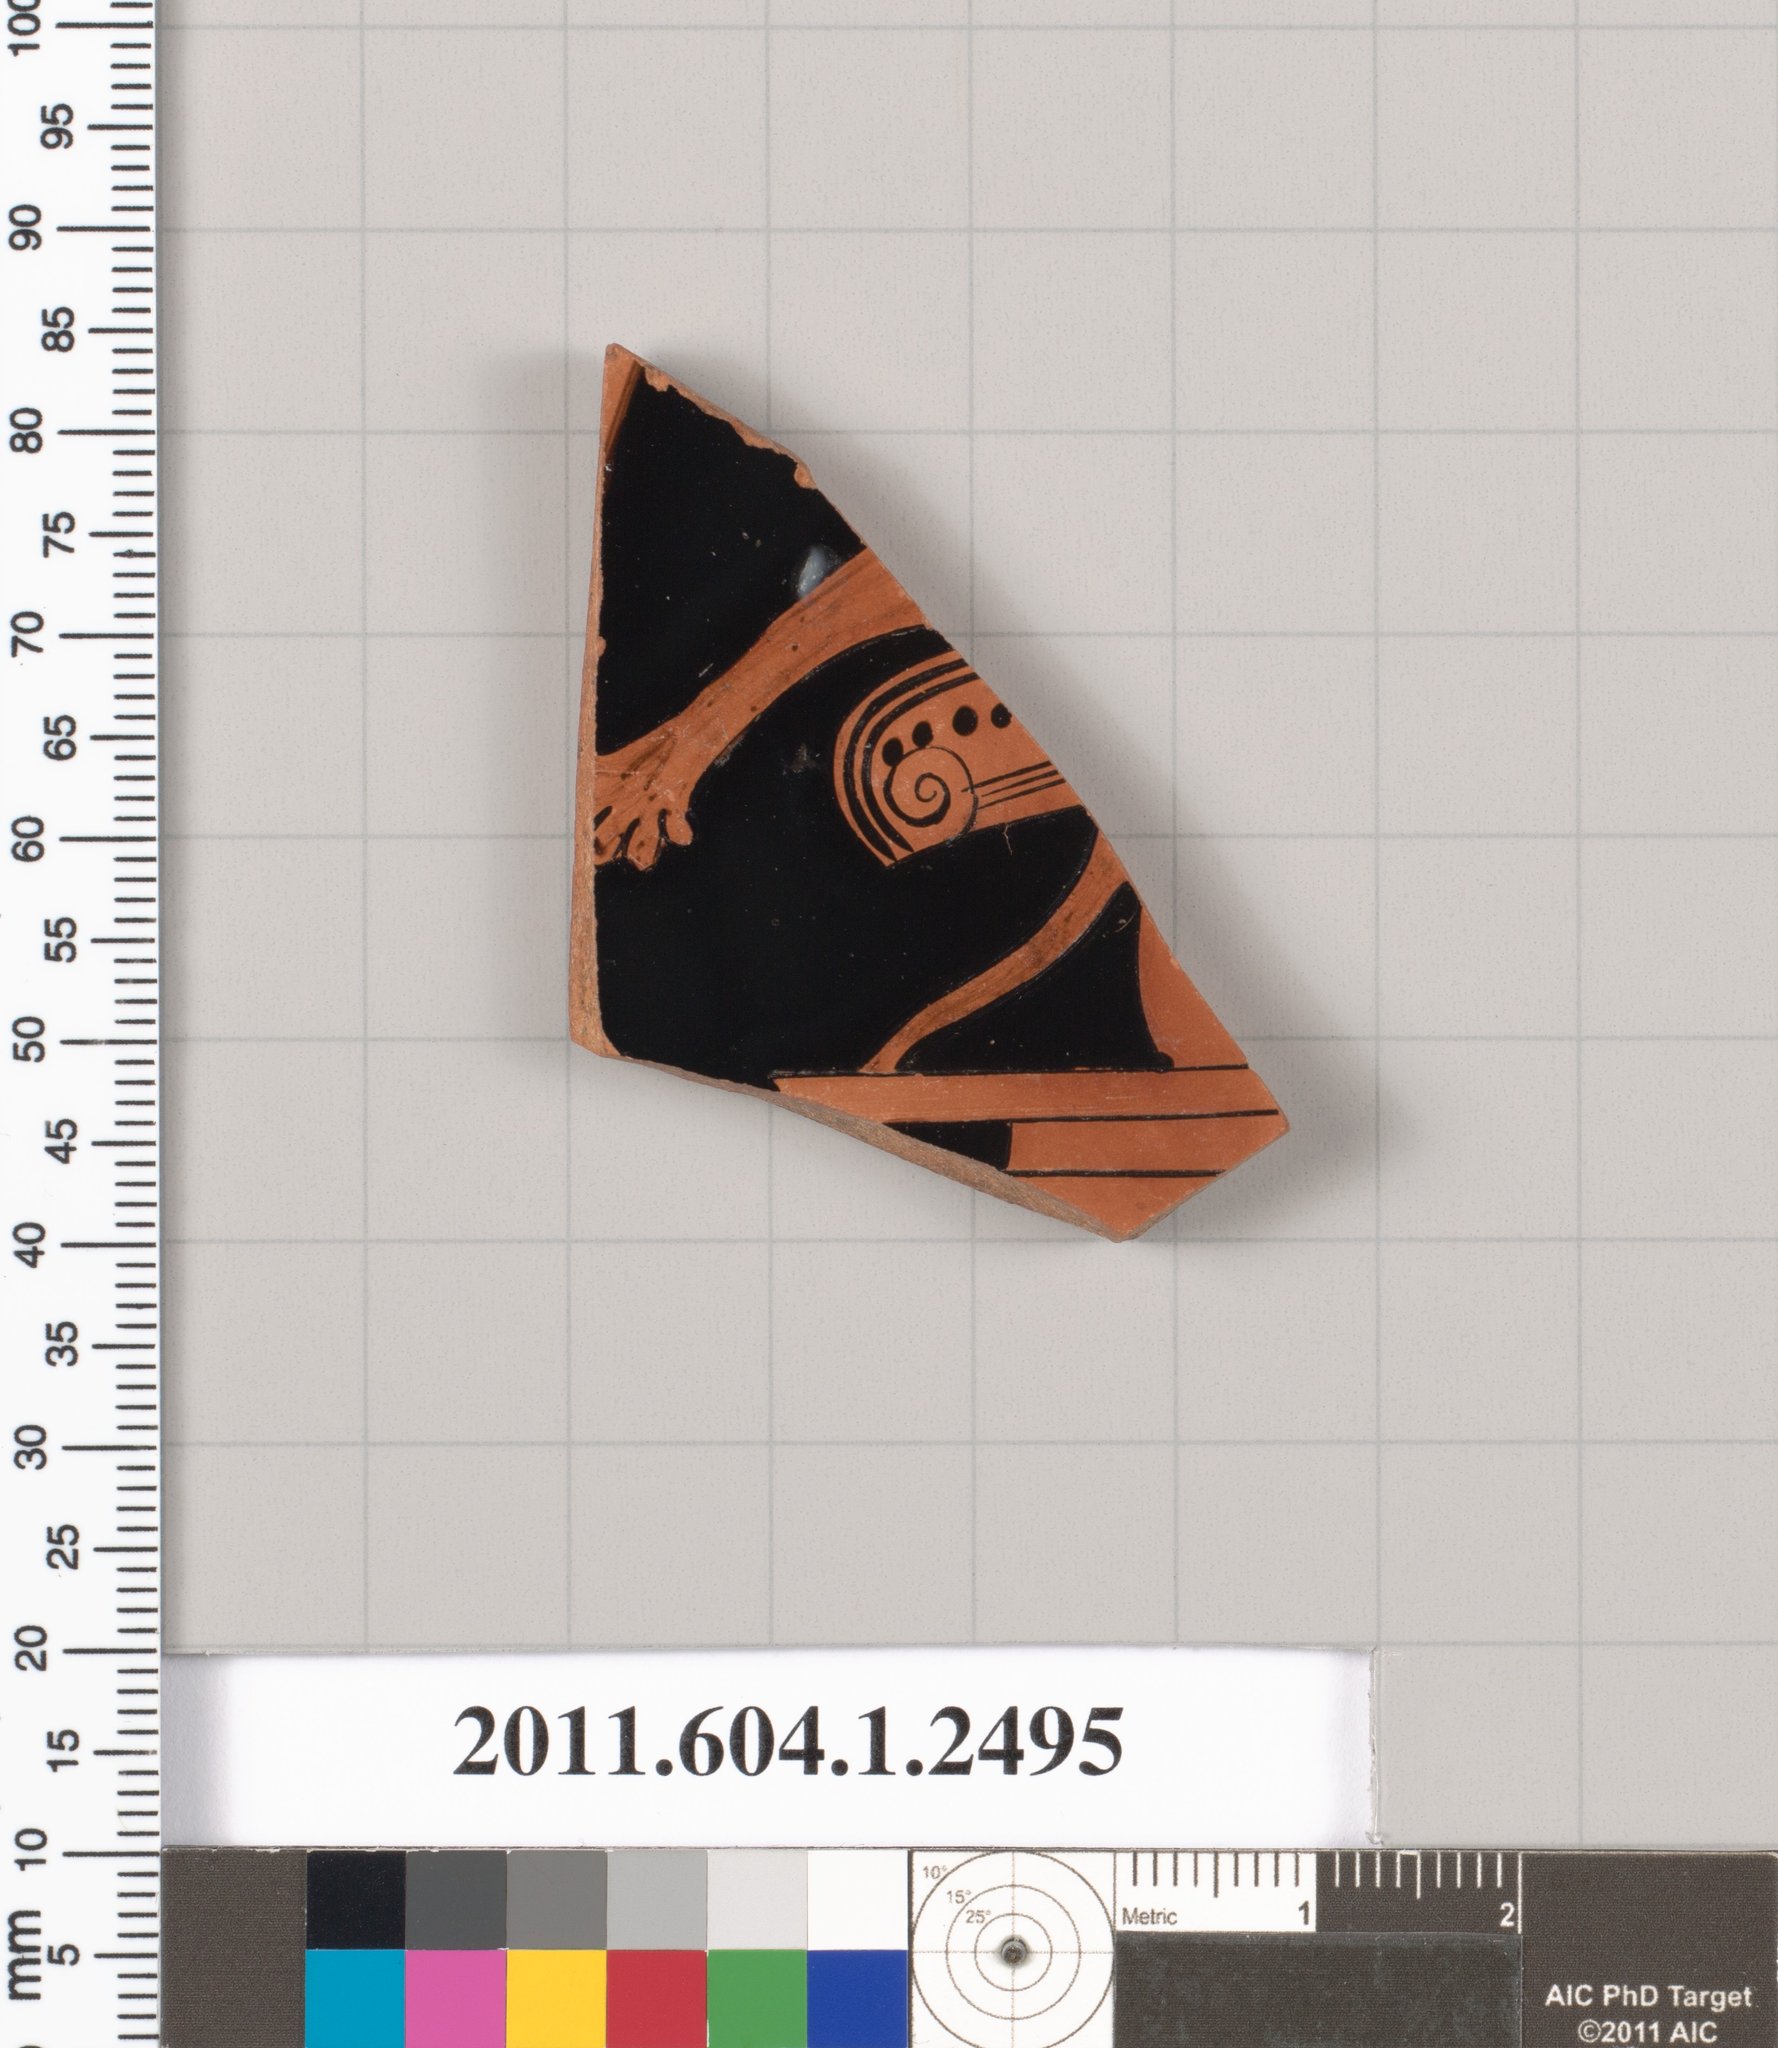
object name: kylix fragment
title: Terracotta fragment of a kylix (drinking cup)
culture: greek, attic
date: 490-480 BCE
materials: terracotta